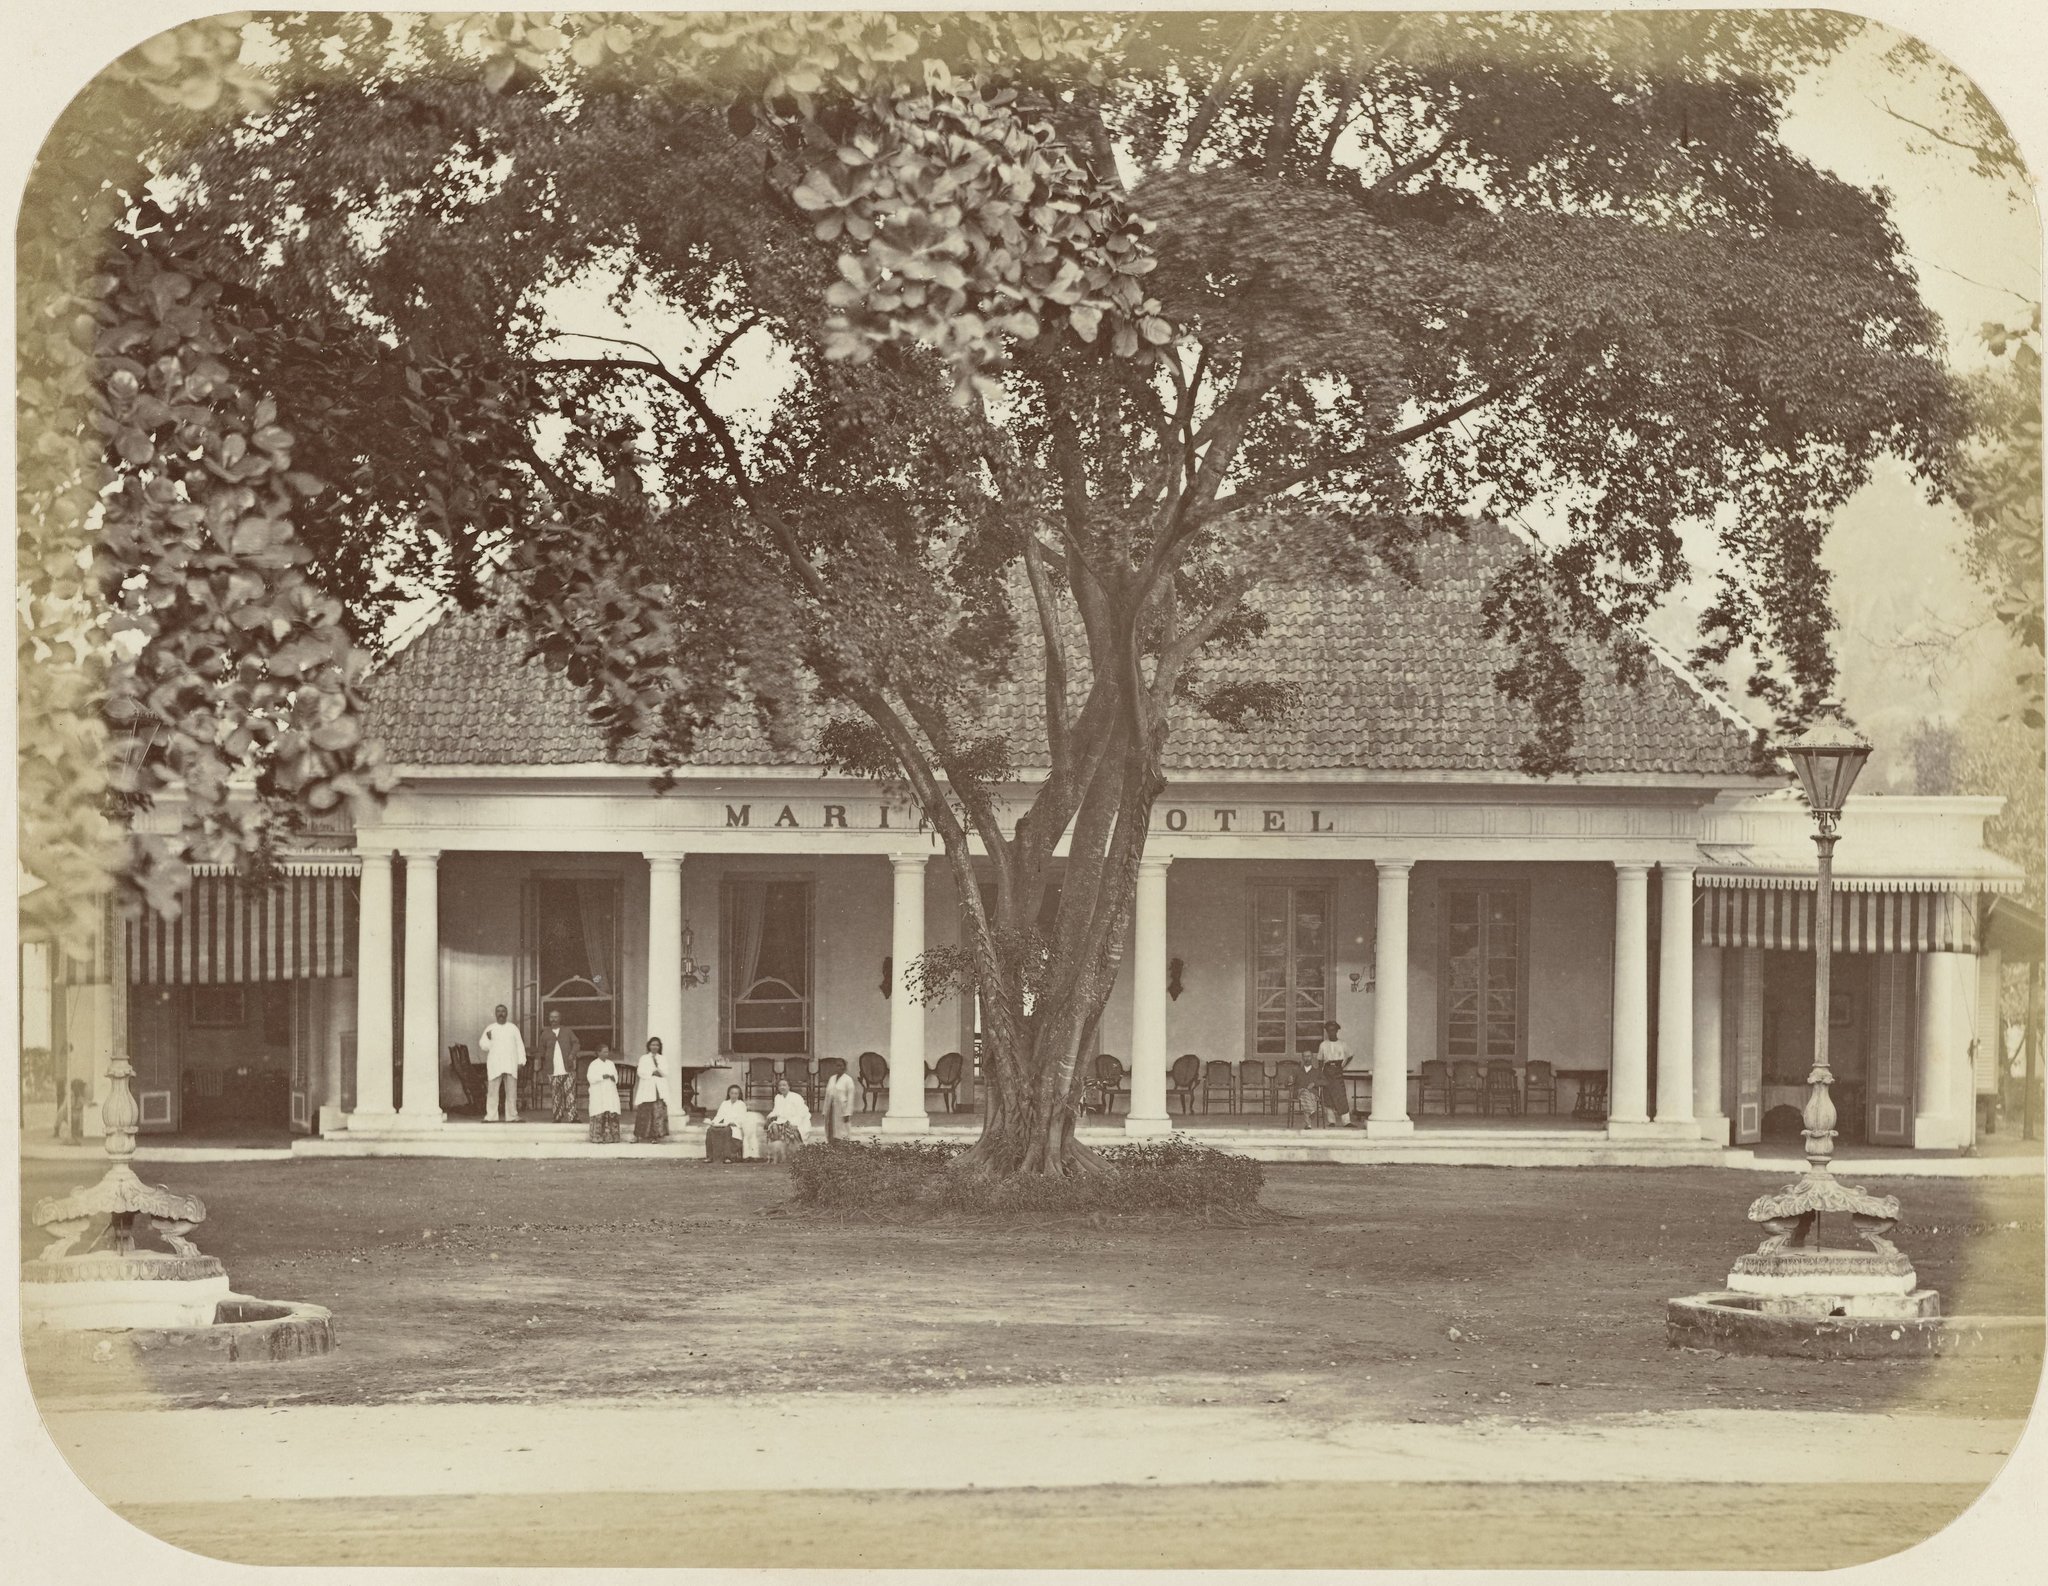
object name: photograph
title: Marine Hotel te Batavia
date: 1868-1872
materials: photographic support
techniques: albumen print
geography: batavia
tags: hotel, hostelry, inn, java, batavia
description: Het Marine Hotel te Batavia, bij de veranda enkele Europeanen, op de voorgrond een gietijzeren straatlantaarn. Ingeplakte foto in het fotoalbum getiteld: Gezichten van Java.